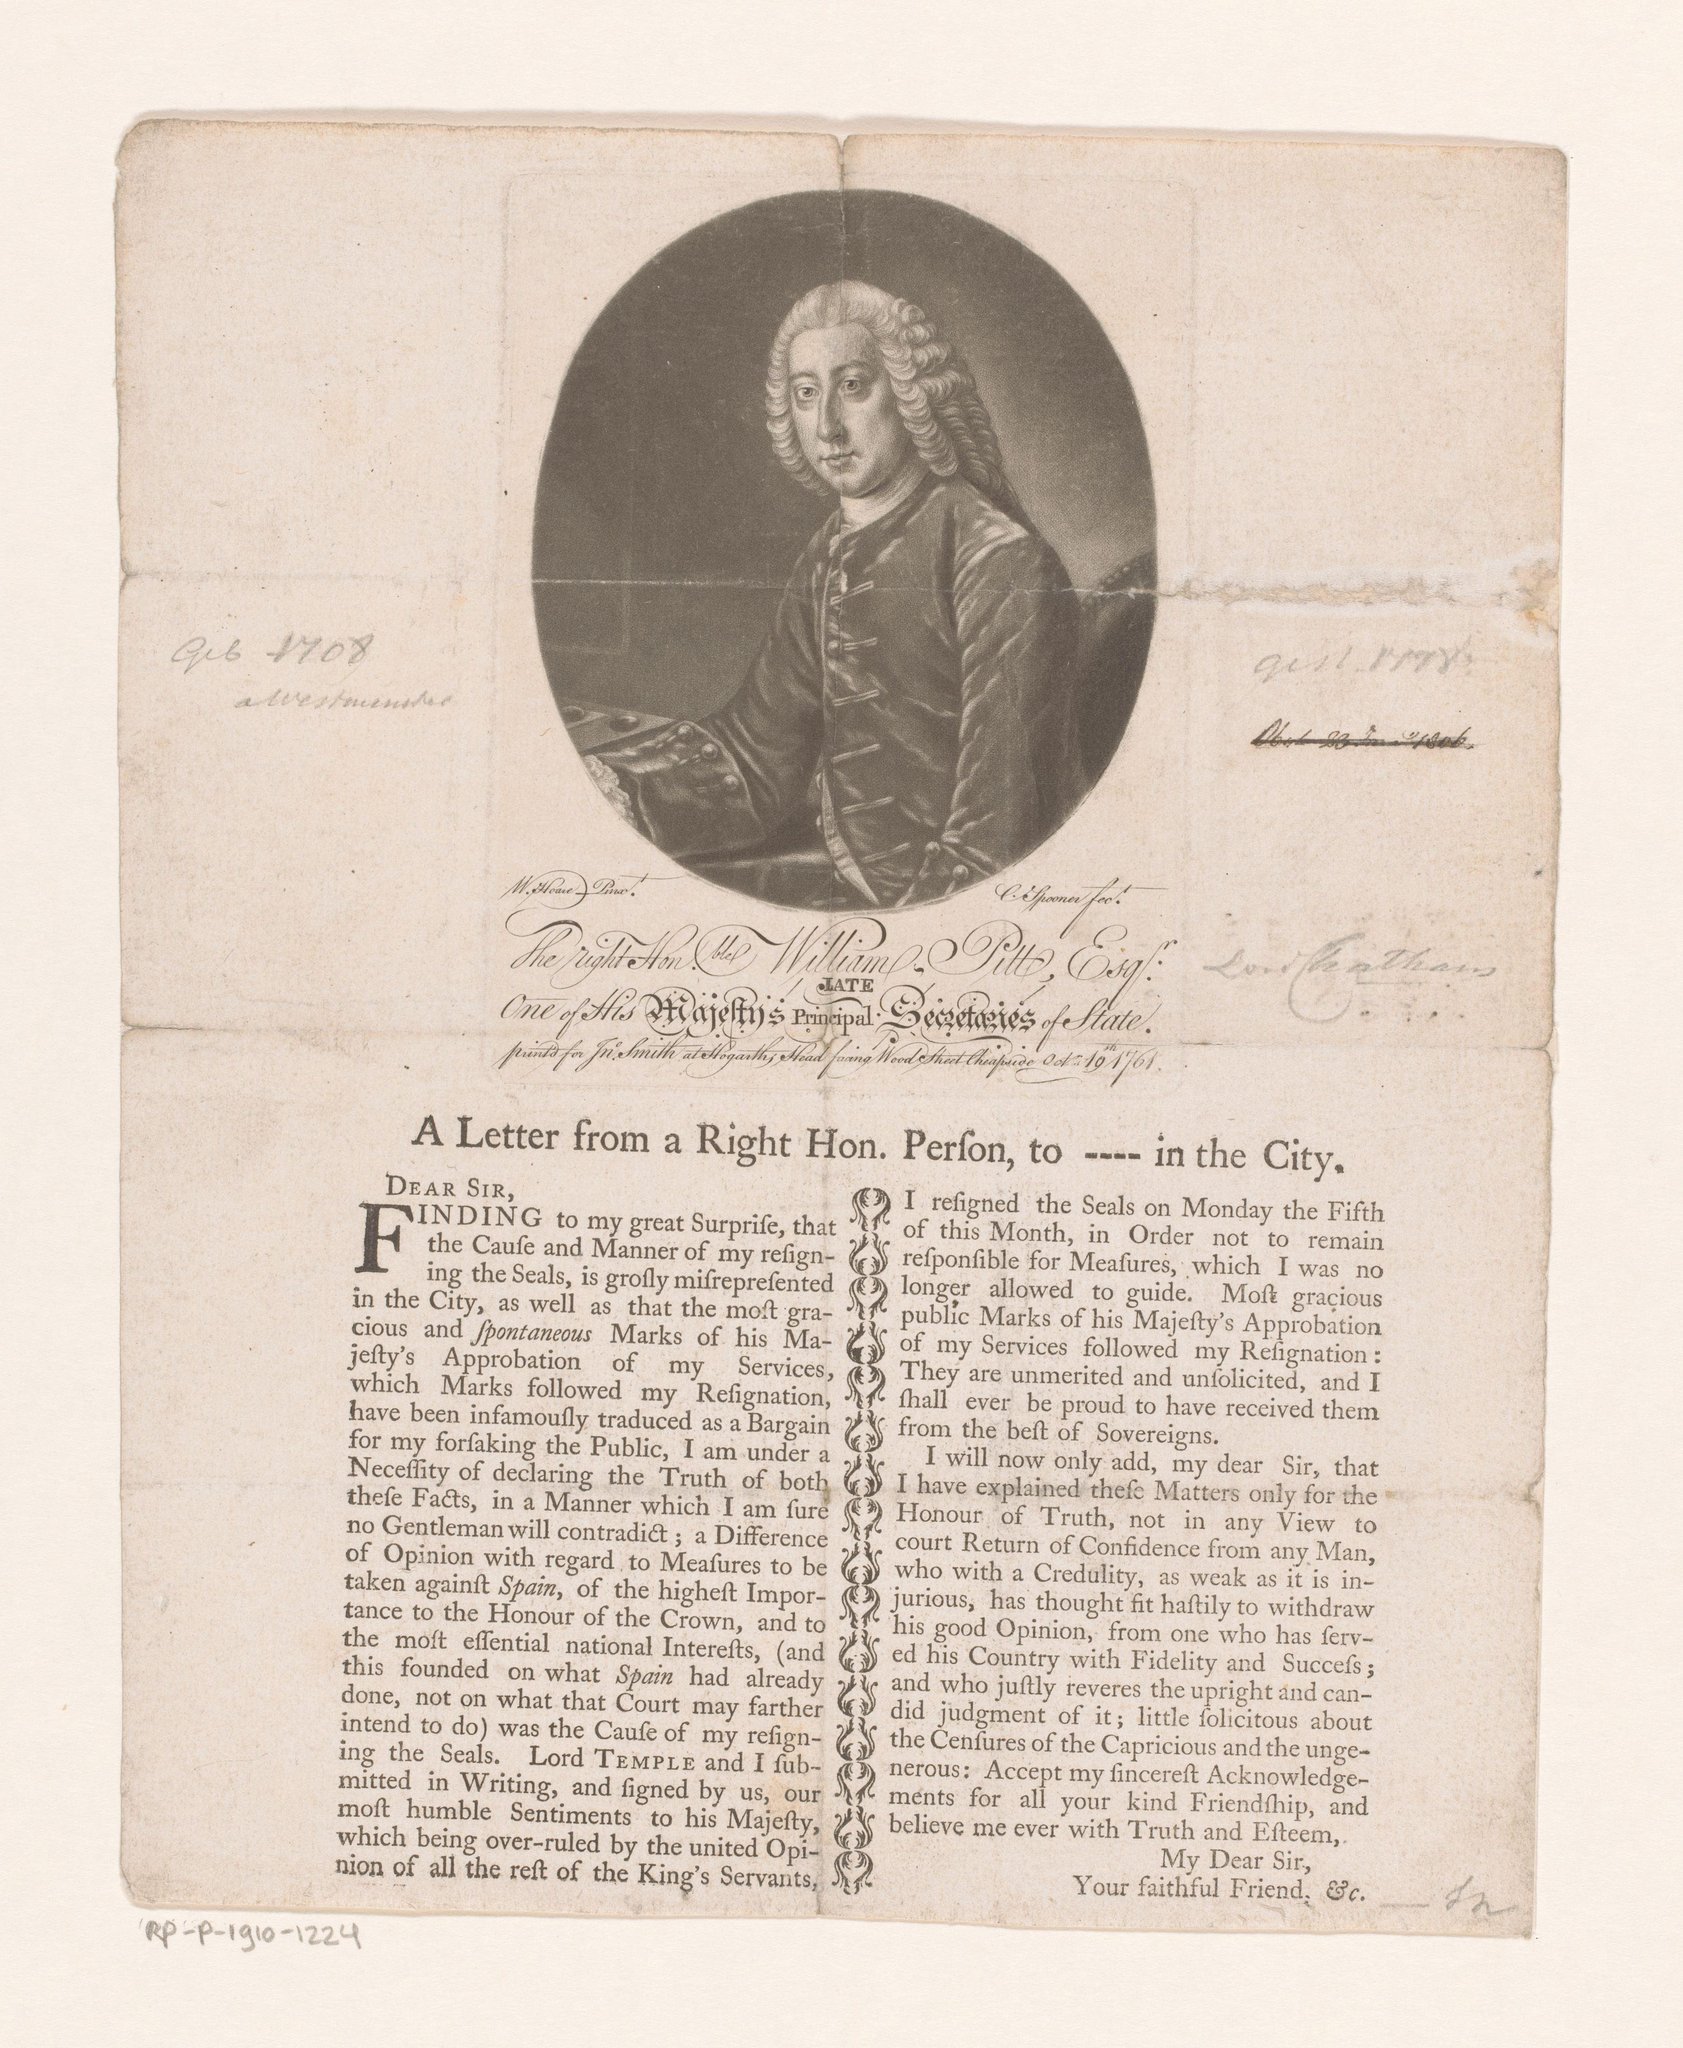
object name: print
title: Portret van William Pitt de Oudere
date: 1710-1761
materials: paper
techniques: letterpress printing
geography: london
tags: london, earl, politician, william pitt (i), historical persons, politician, e.g. party leader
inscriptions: inscription, collector's mark: Lugt 2228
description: Onder de prent een publieke brief waarin het terugtreden van William Pitt als minister wordt uitgelegd.